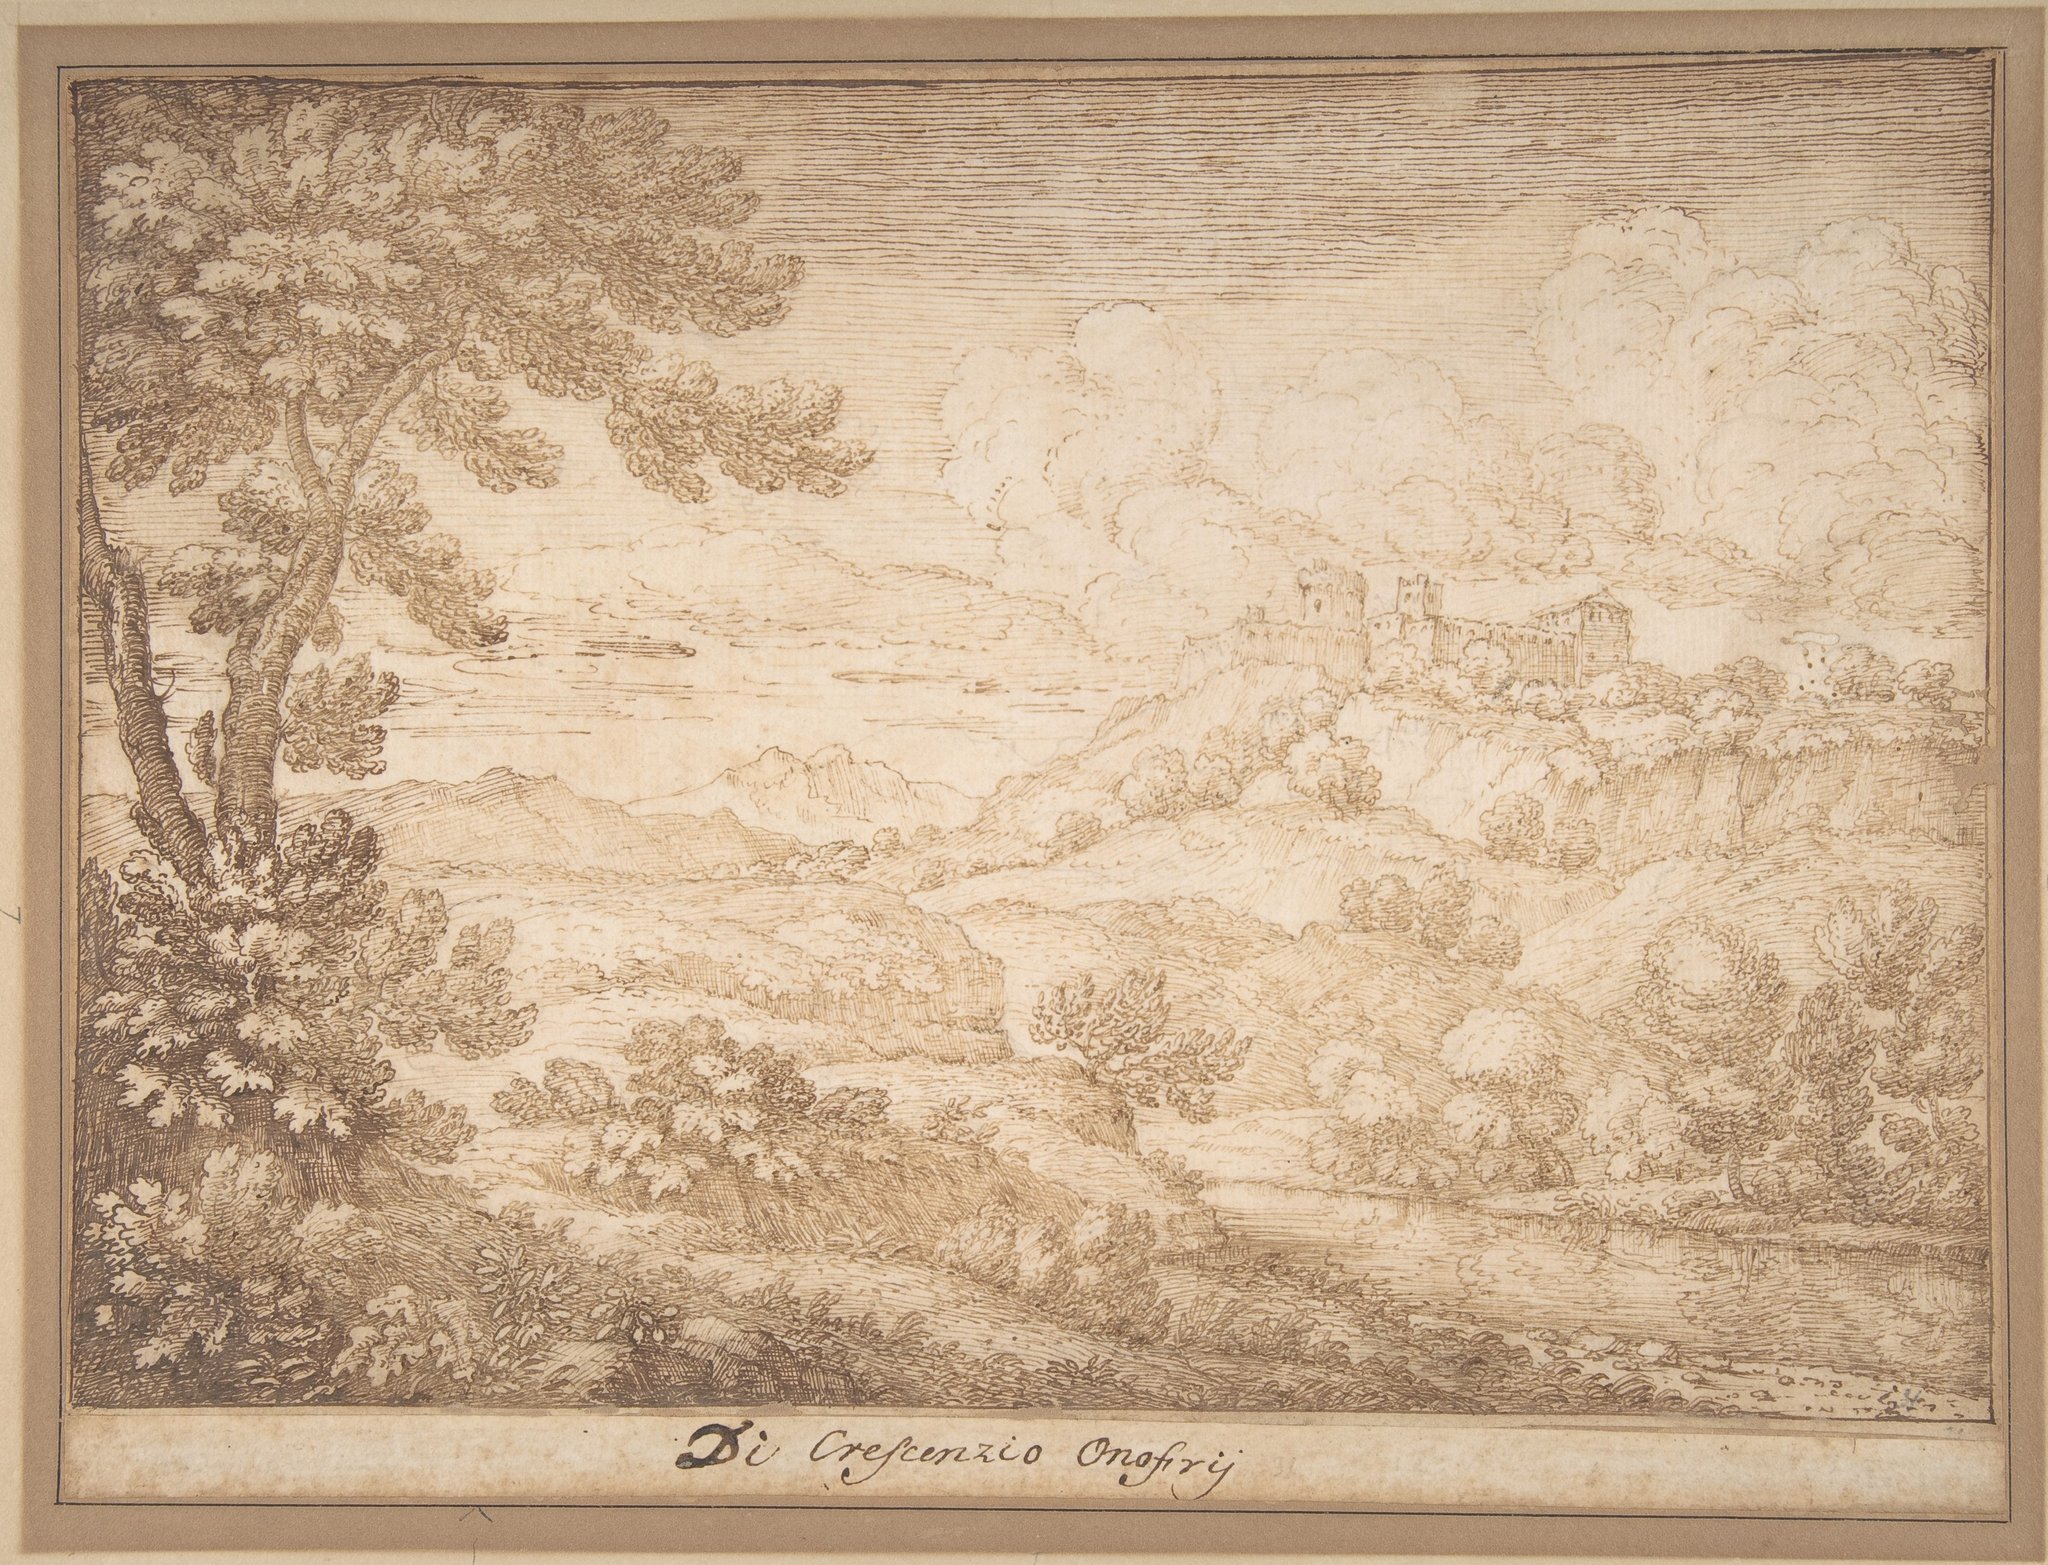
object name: drawing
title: Landscape with a Castle on a Hill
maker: crescenzio onofri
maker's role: artist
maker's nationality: italian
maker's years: 1632-1712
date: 1632-1712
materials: ink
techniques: pen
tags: hills,landscapes,trees